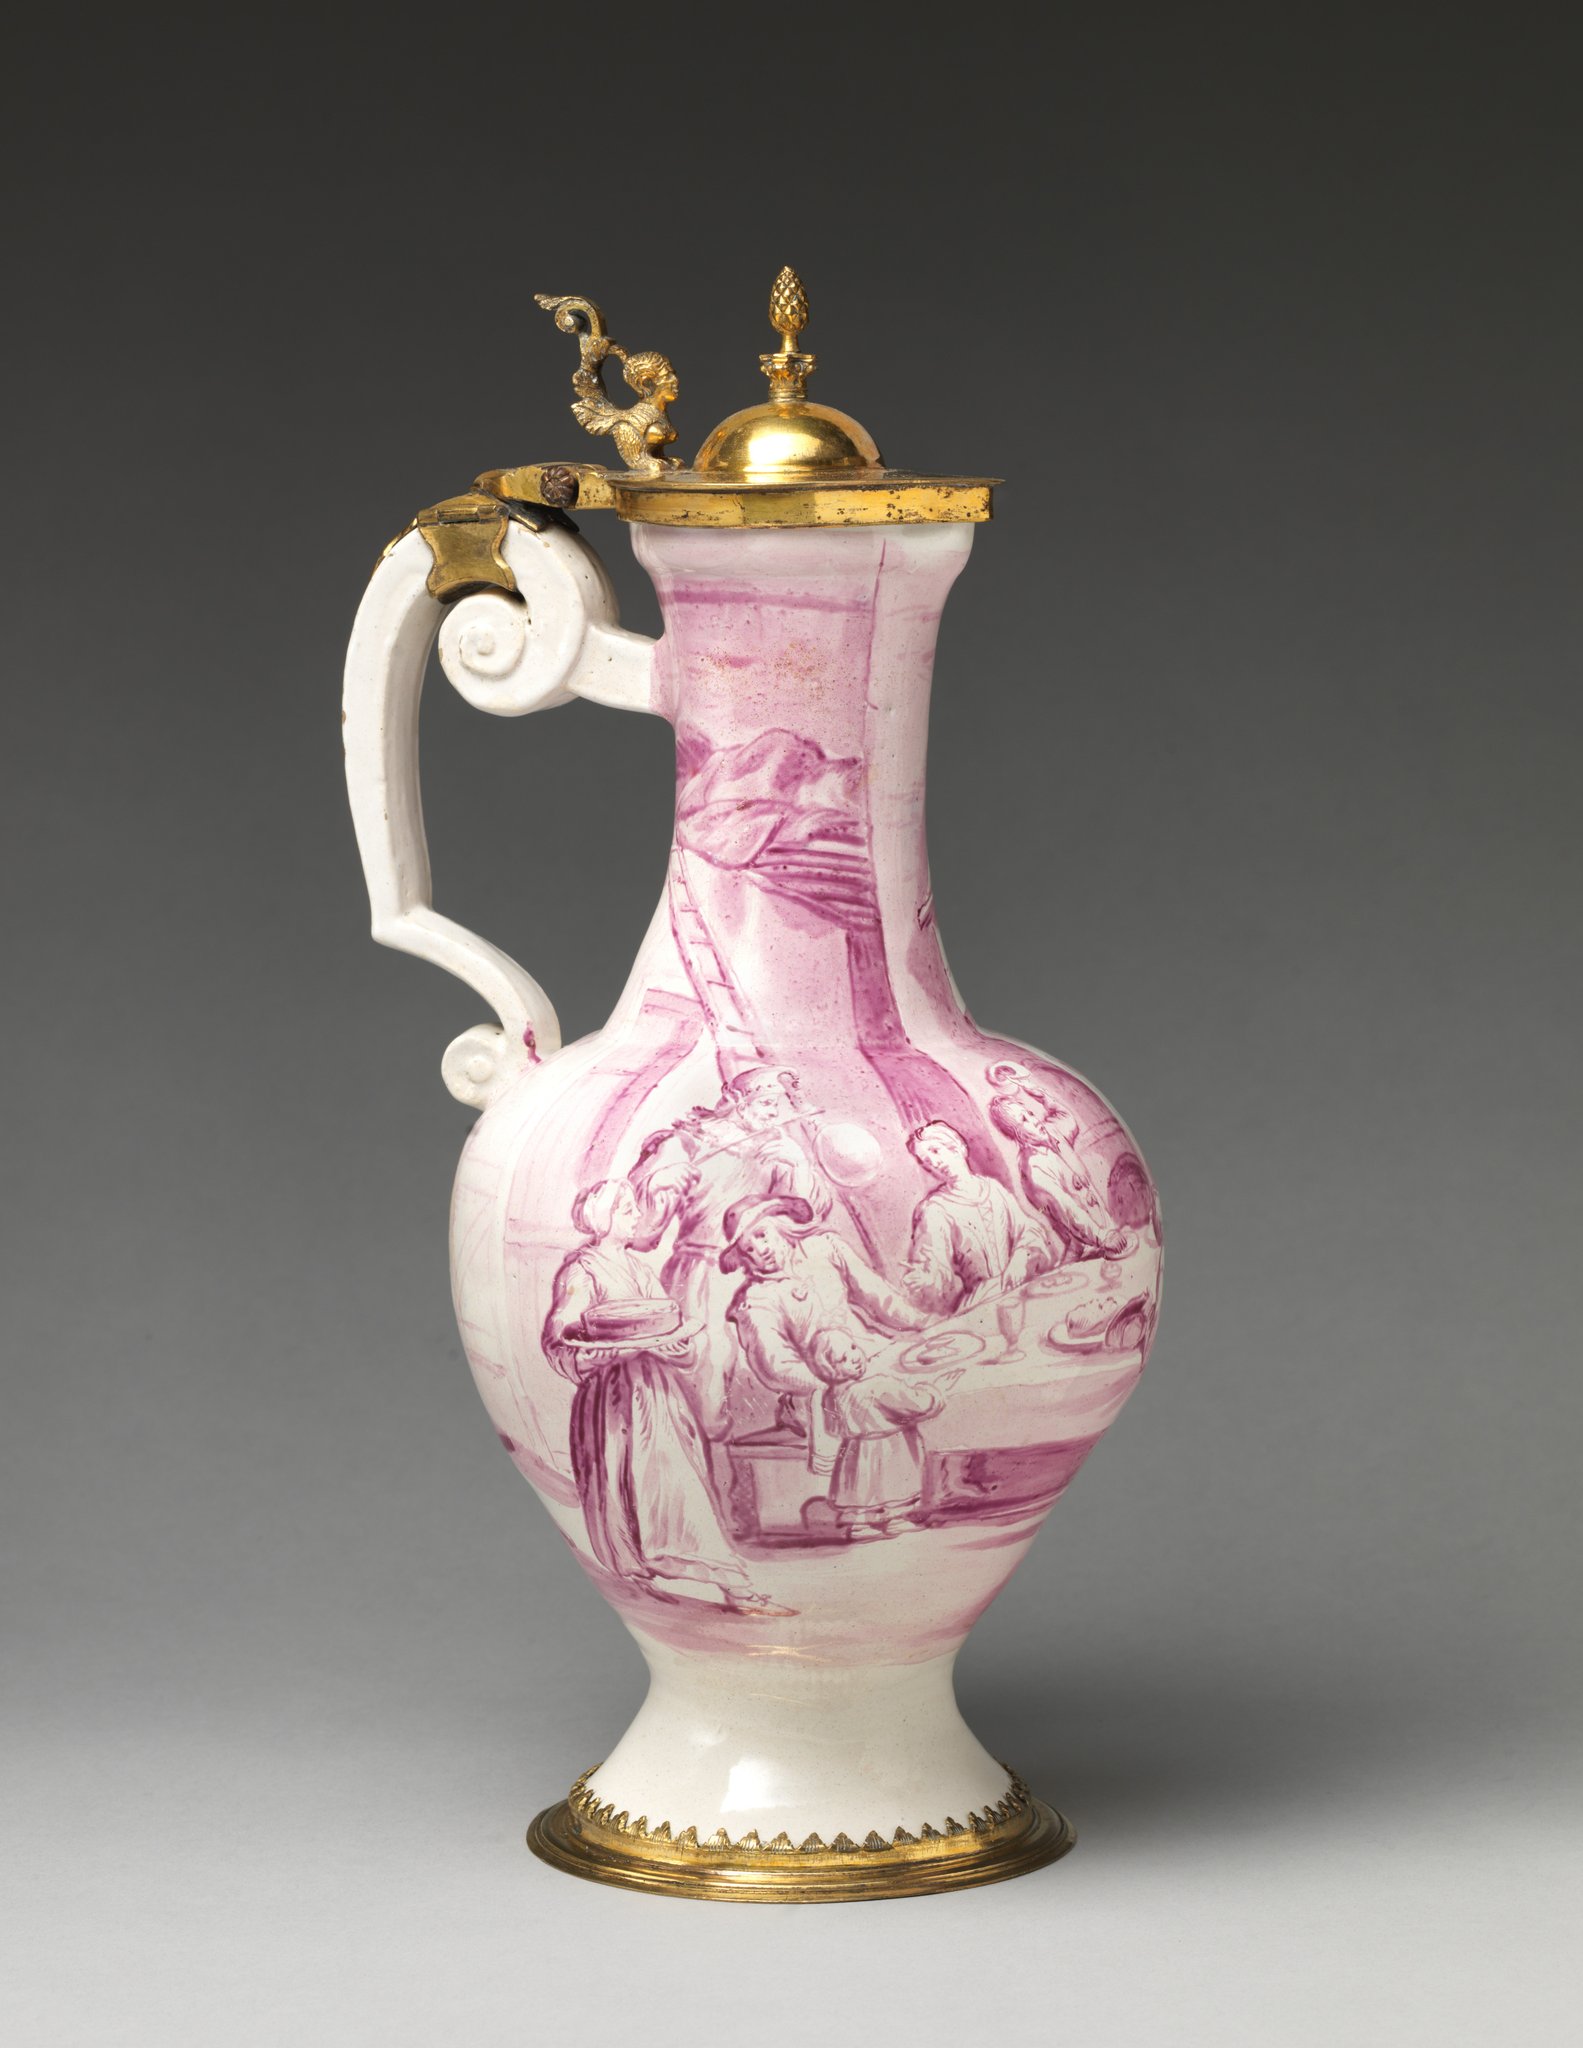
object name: jug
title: Jug (one of a pair)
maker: fehr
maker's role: maker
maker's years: 1650-1750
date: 1680-1690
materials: brass, earthenware, gilt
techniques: glazing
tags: men,women